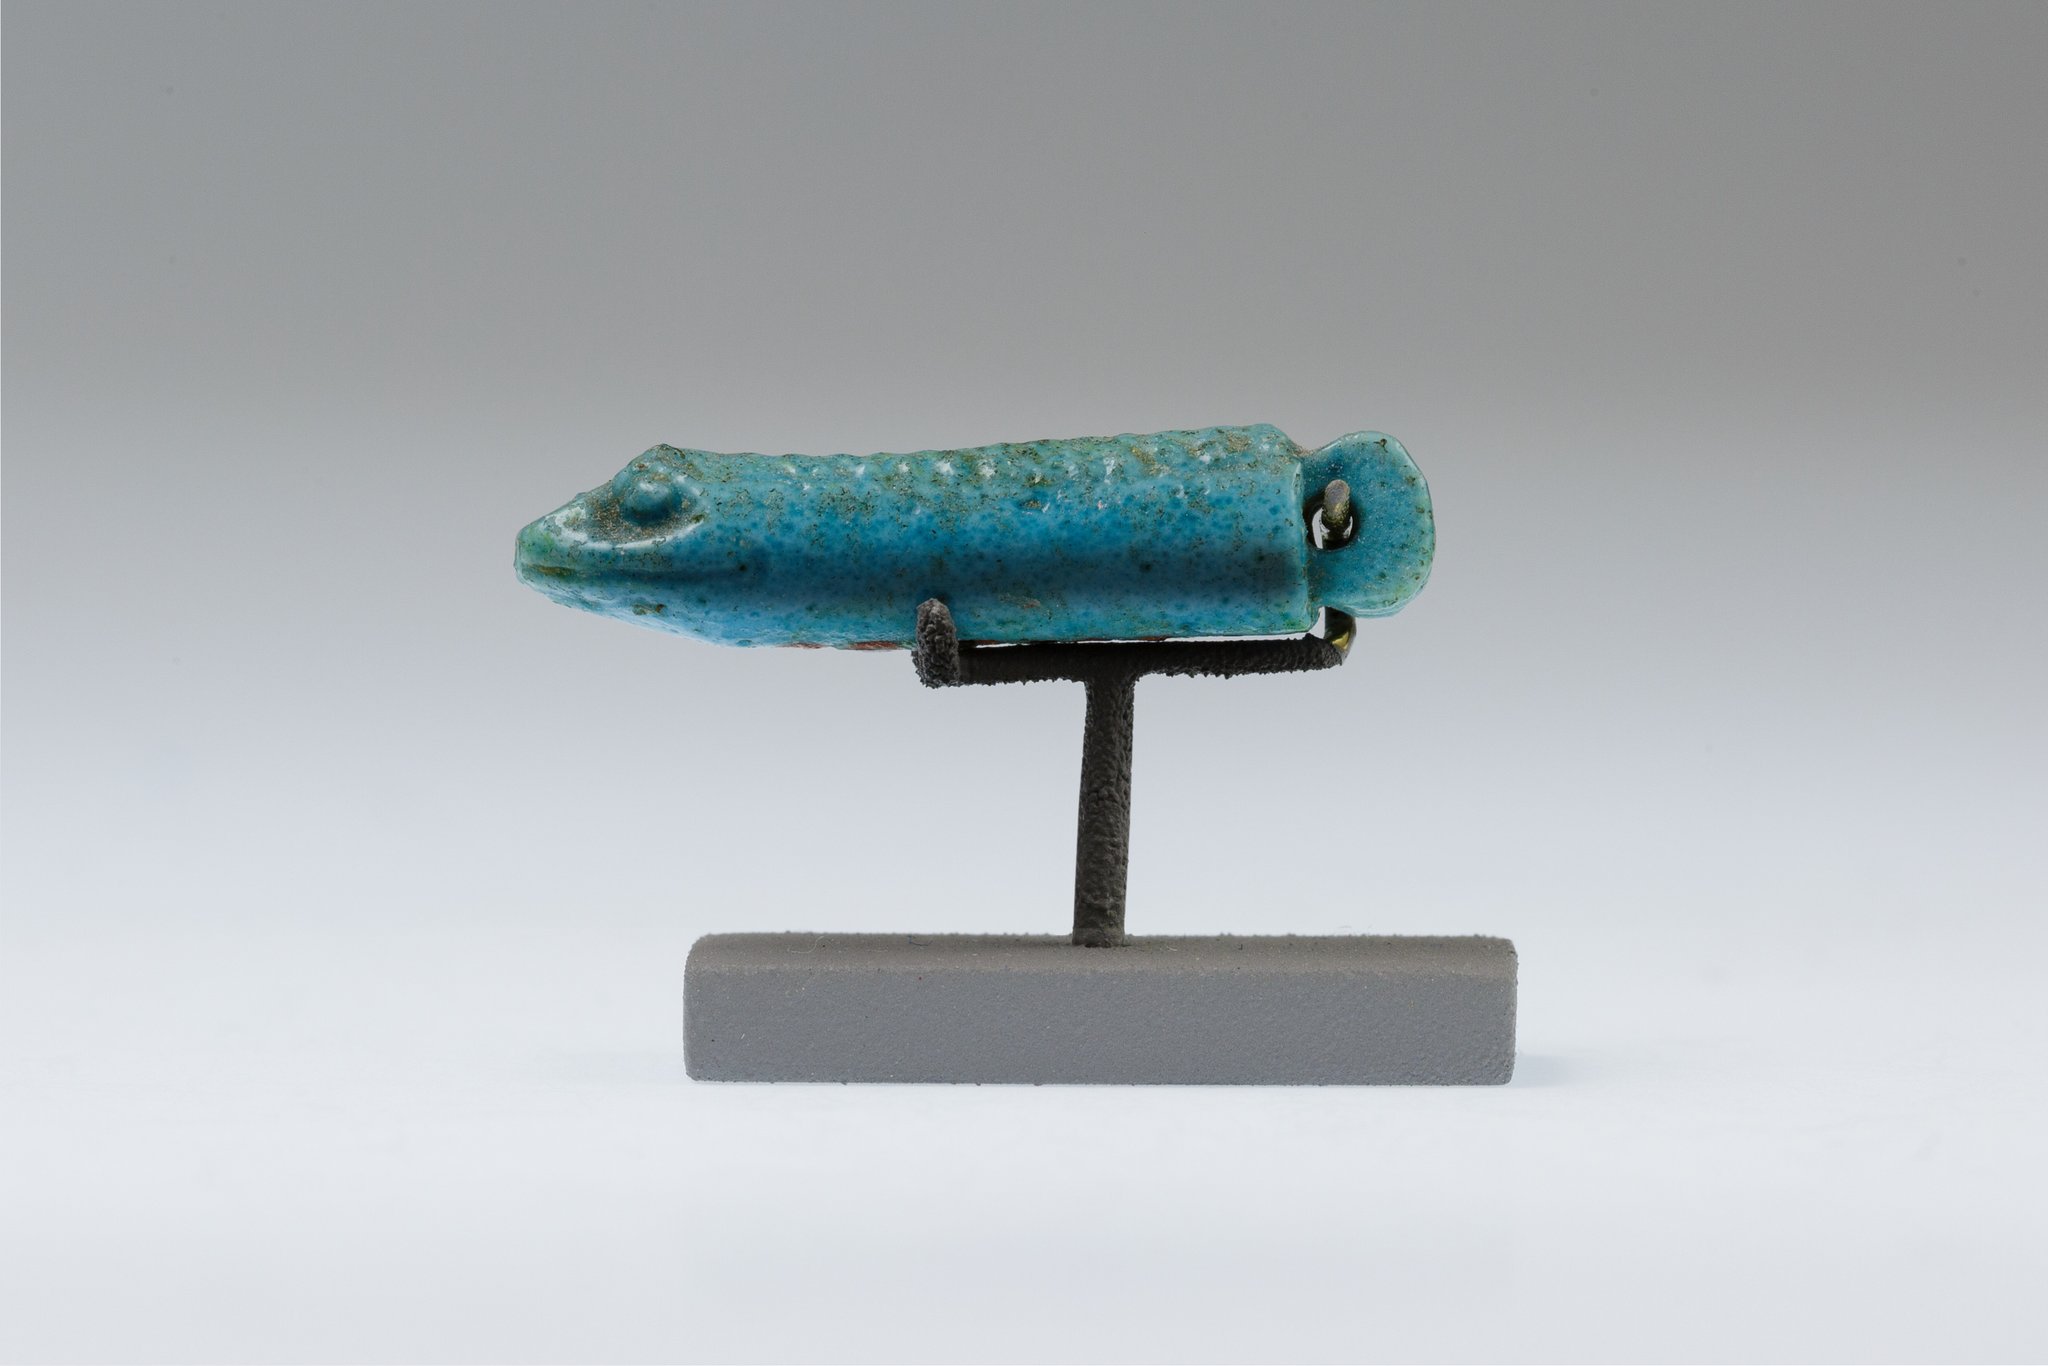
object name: amulet, snake head menqebit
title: Menqebit (snake's head) amulet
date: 664-332 BCE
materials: faience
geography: egypt